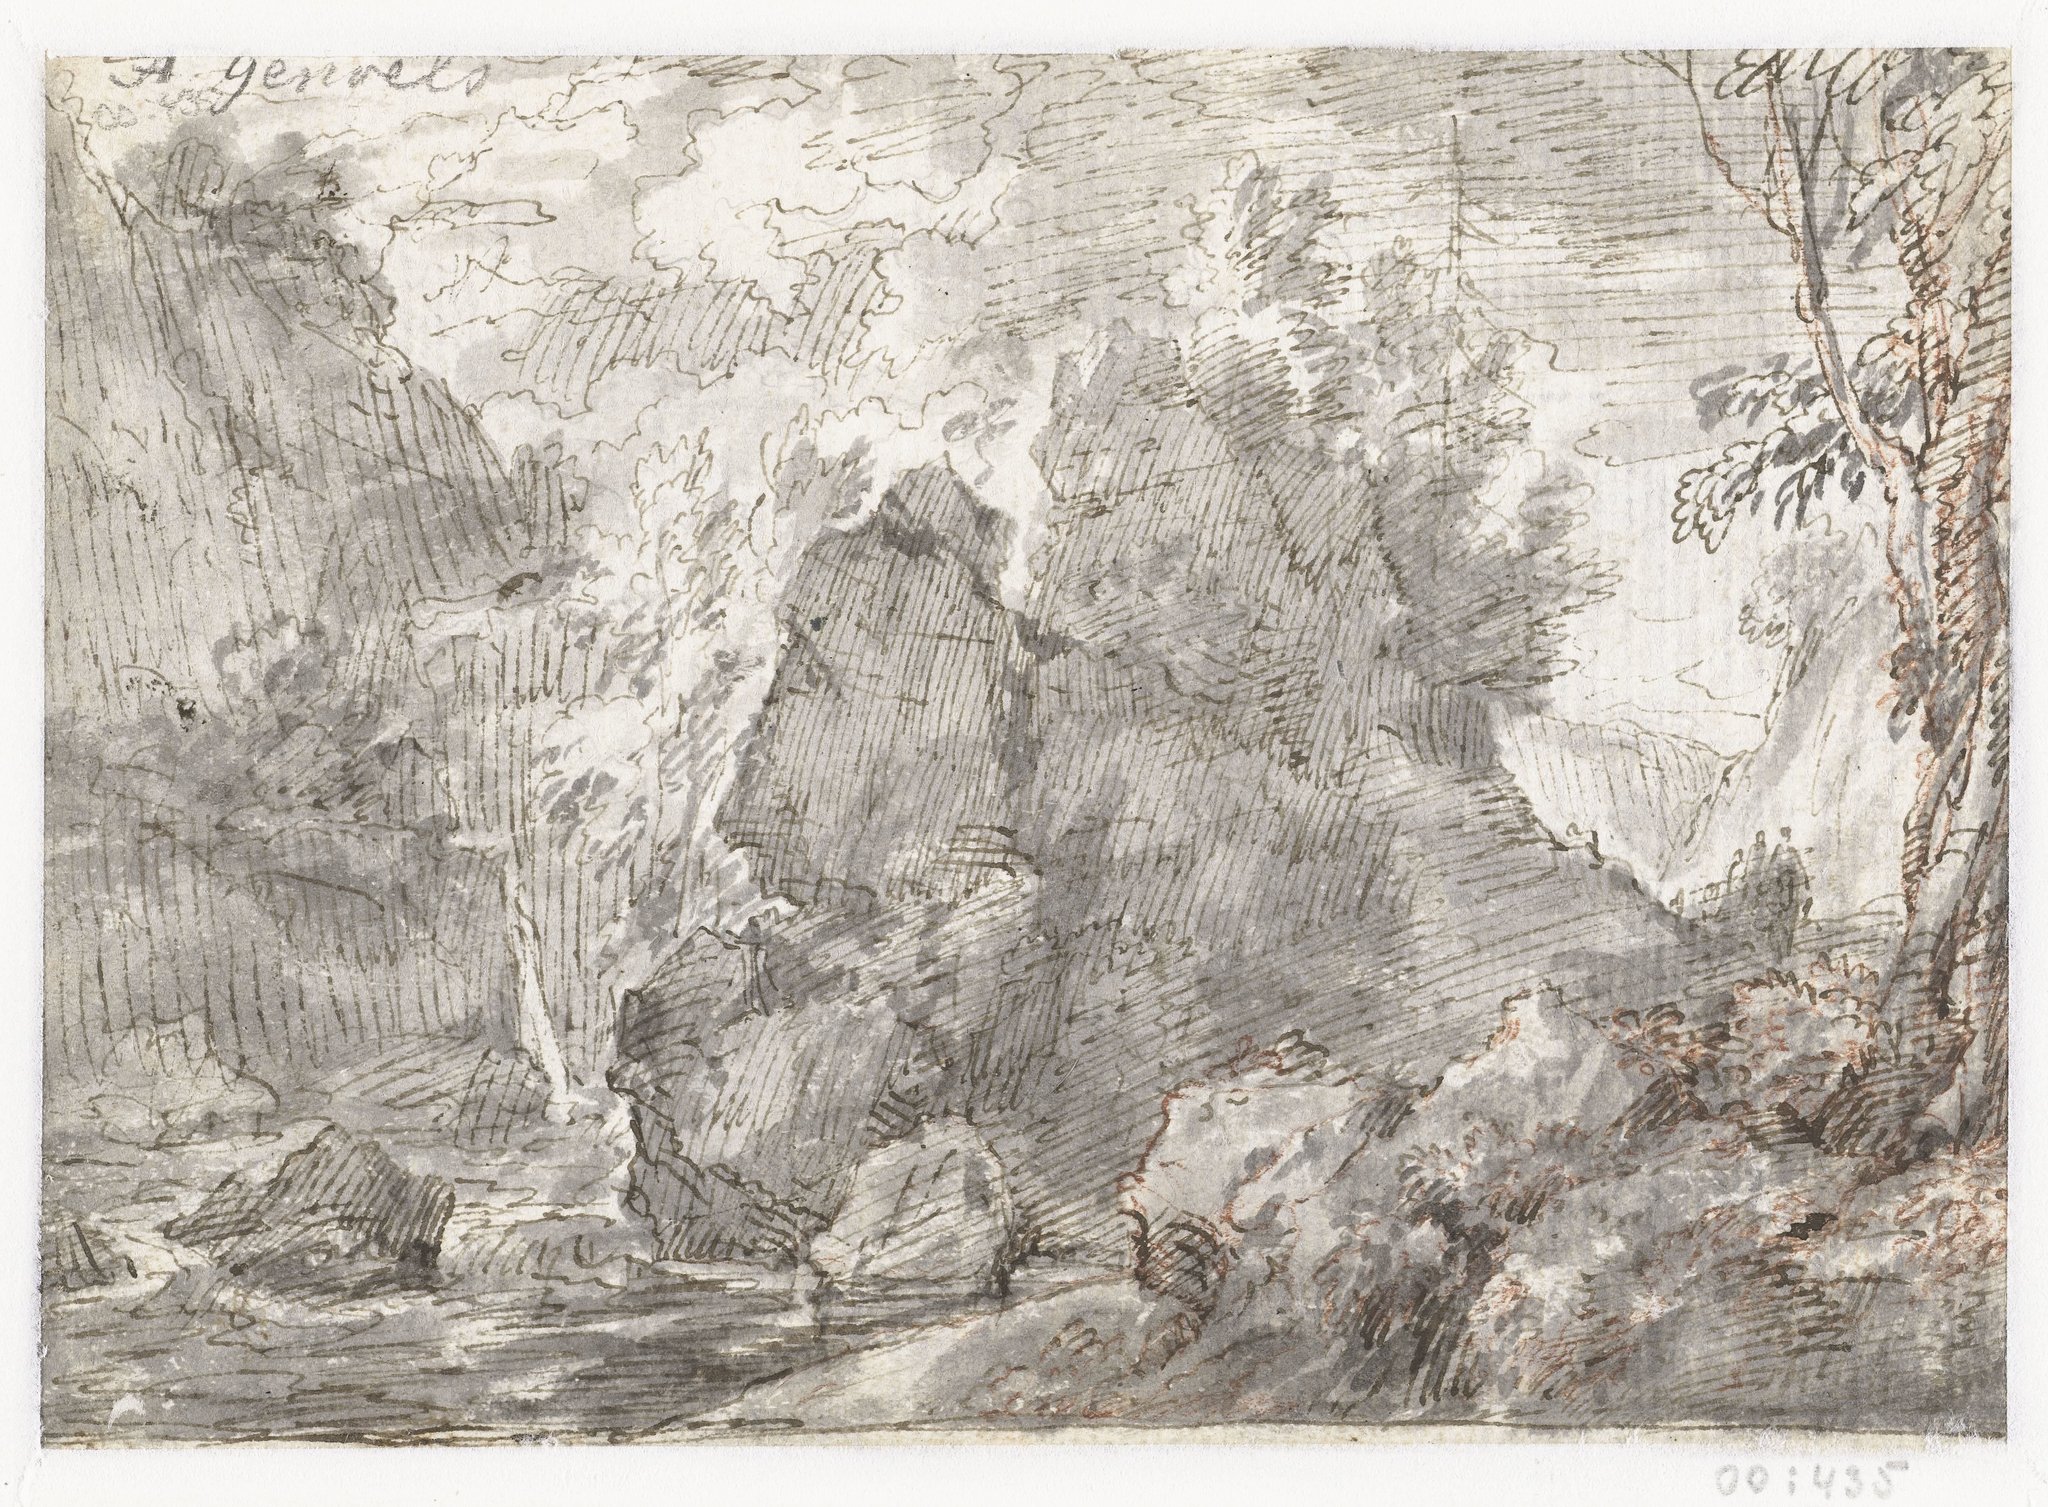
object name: drawing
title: Rotsblokken en bomen bij een beek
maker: abraham genoels (ii)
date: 1686-1688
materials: chalk, ink, paper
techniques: brush, pen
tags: landscapes in the temperate zone